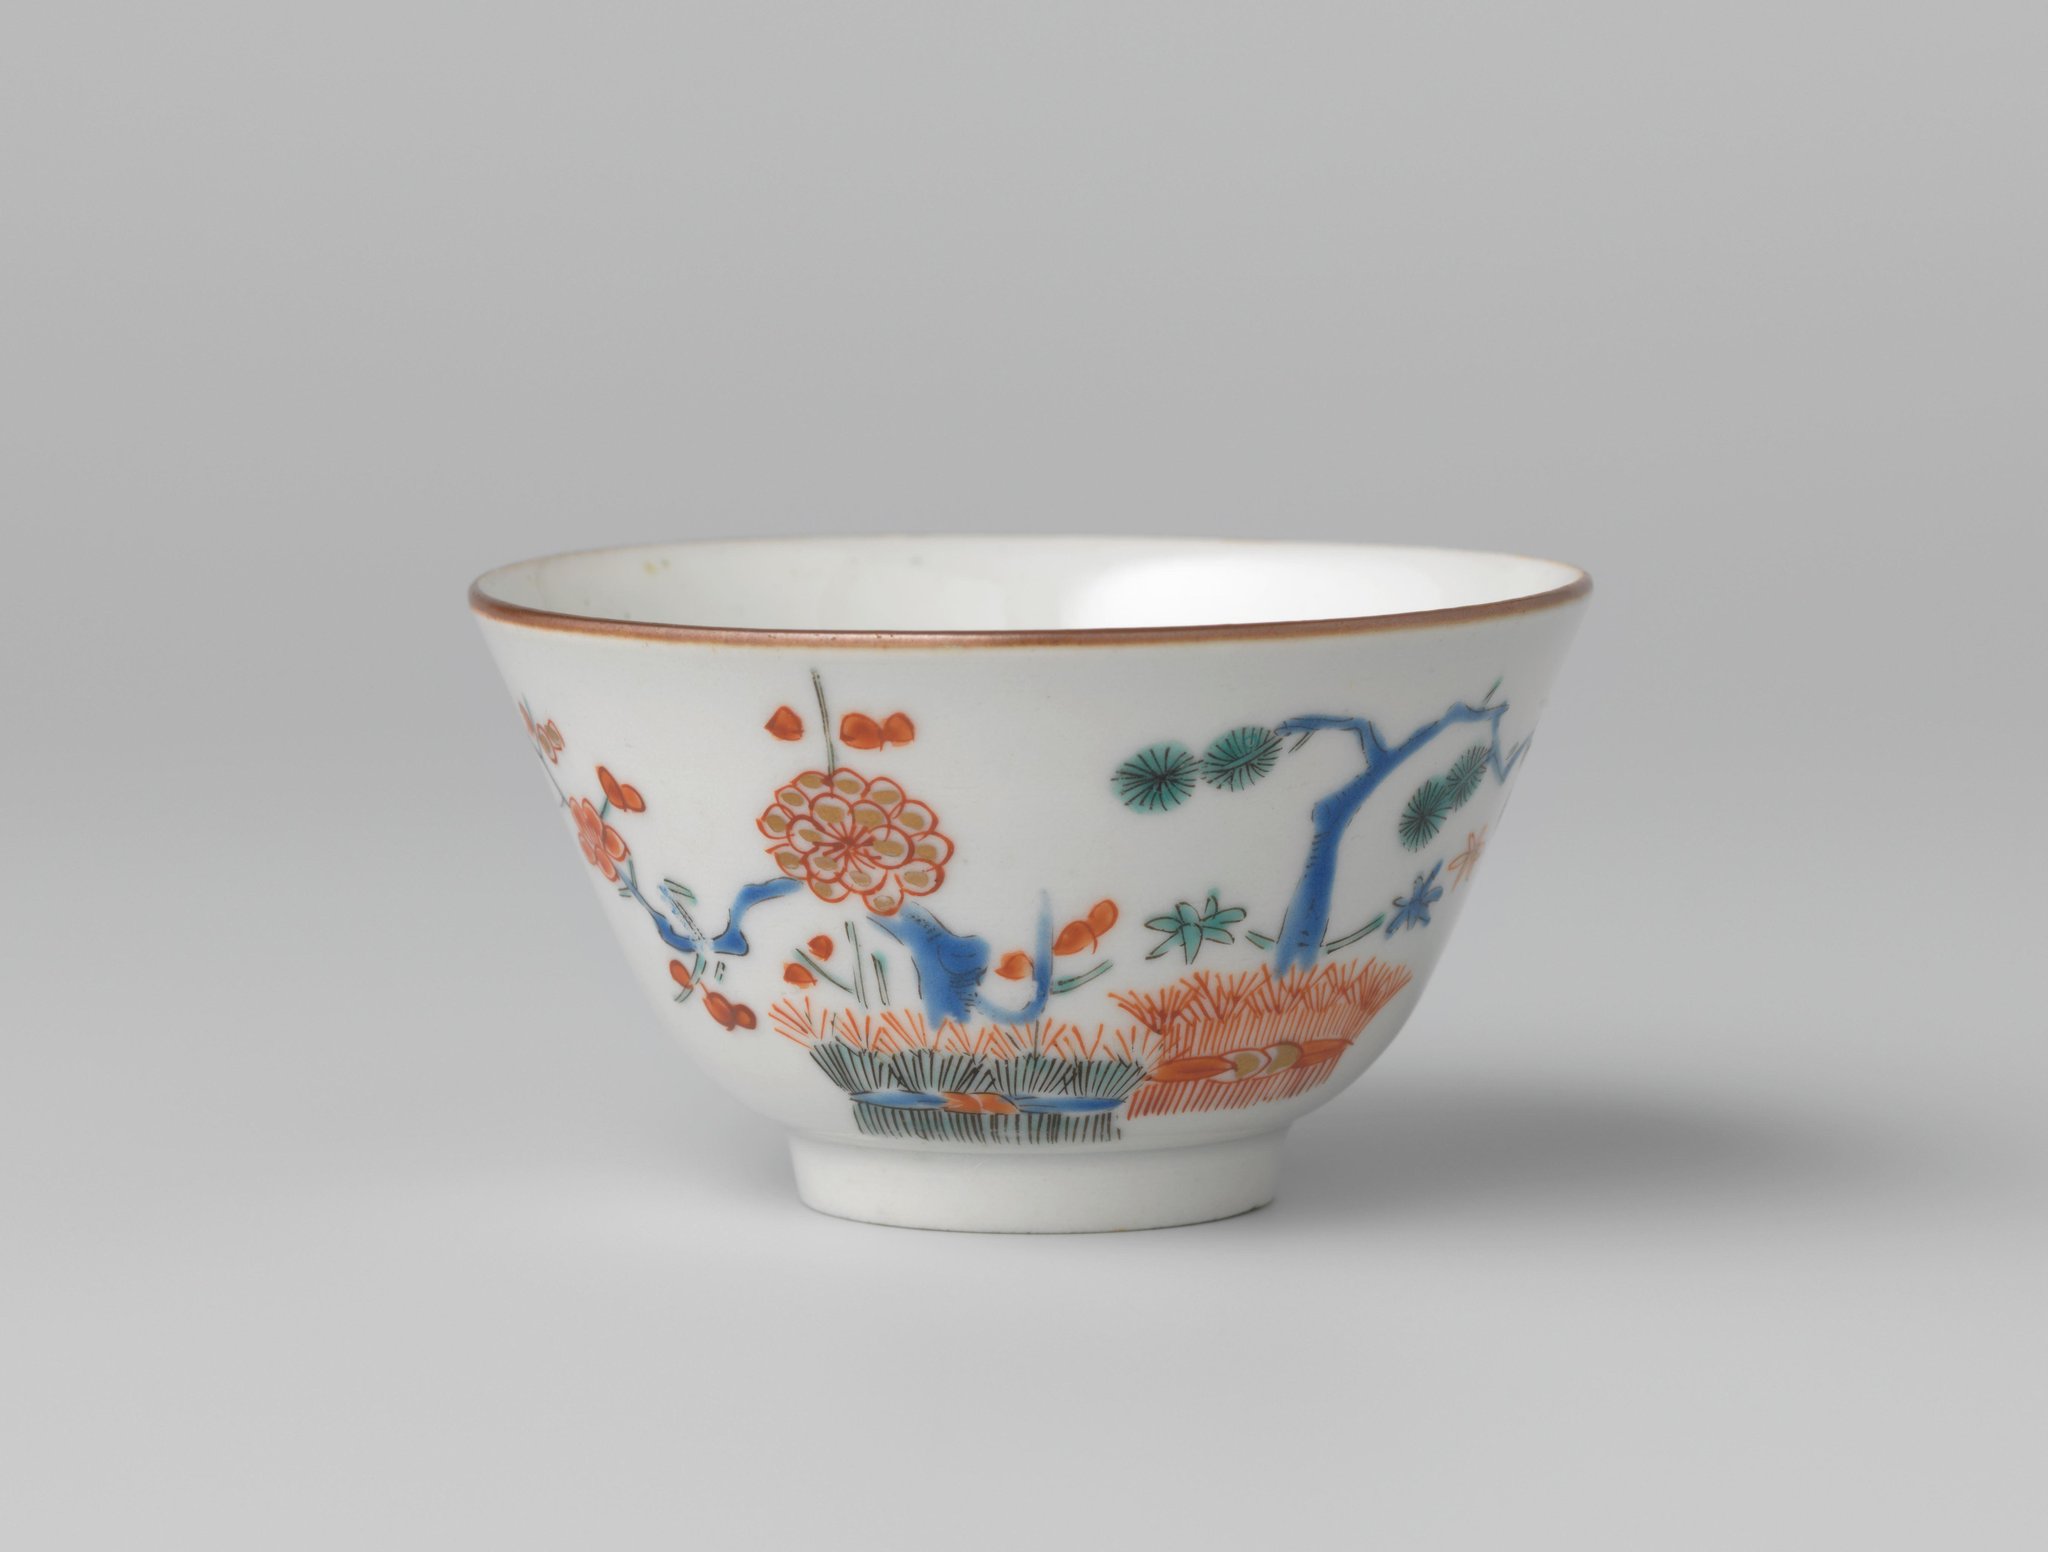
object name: cup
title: Round cup with the 'three friends of winter'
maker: Anonymous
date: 1670-1700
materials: glaze, gold, paint, porcelain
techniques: firing, gilding, turning, vitrification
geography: japan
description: Ronde kop met recht uitlopende wand van porselein, beschilderd op het glazuur in blauw, rood, groen, zwart en goud met de 'drie vrienden van de winter' (bamboe, prunus, pijnboom), bij twee gebonden heggen, een vijfbladige bloem in de kom. Bruine rand. Kakiemon-stijl.